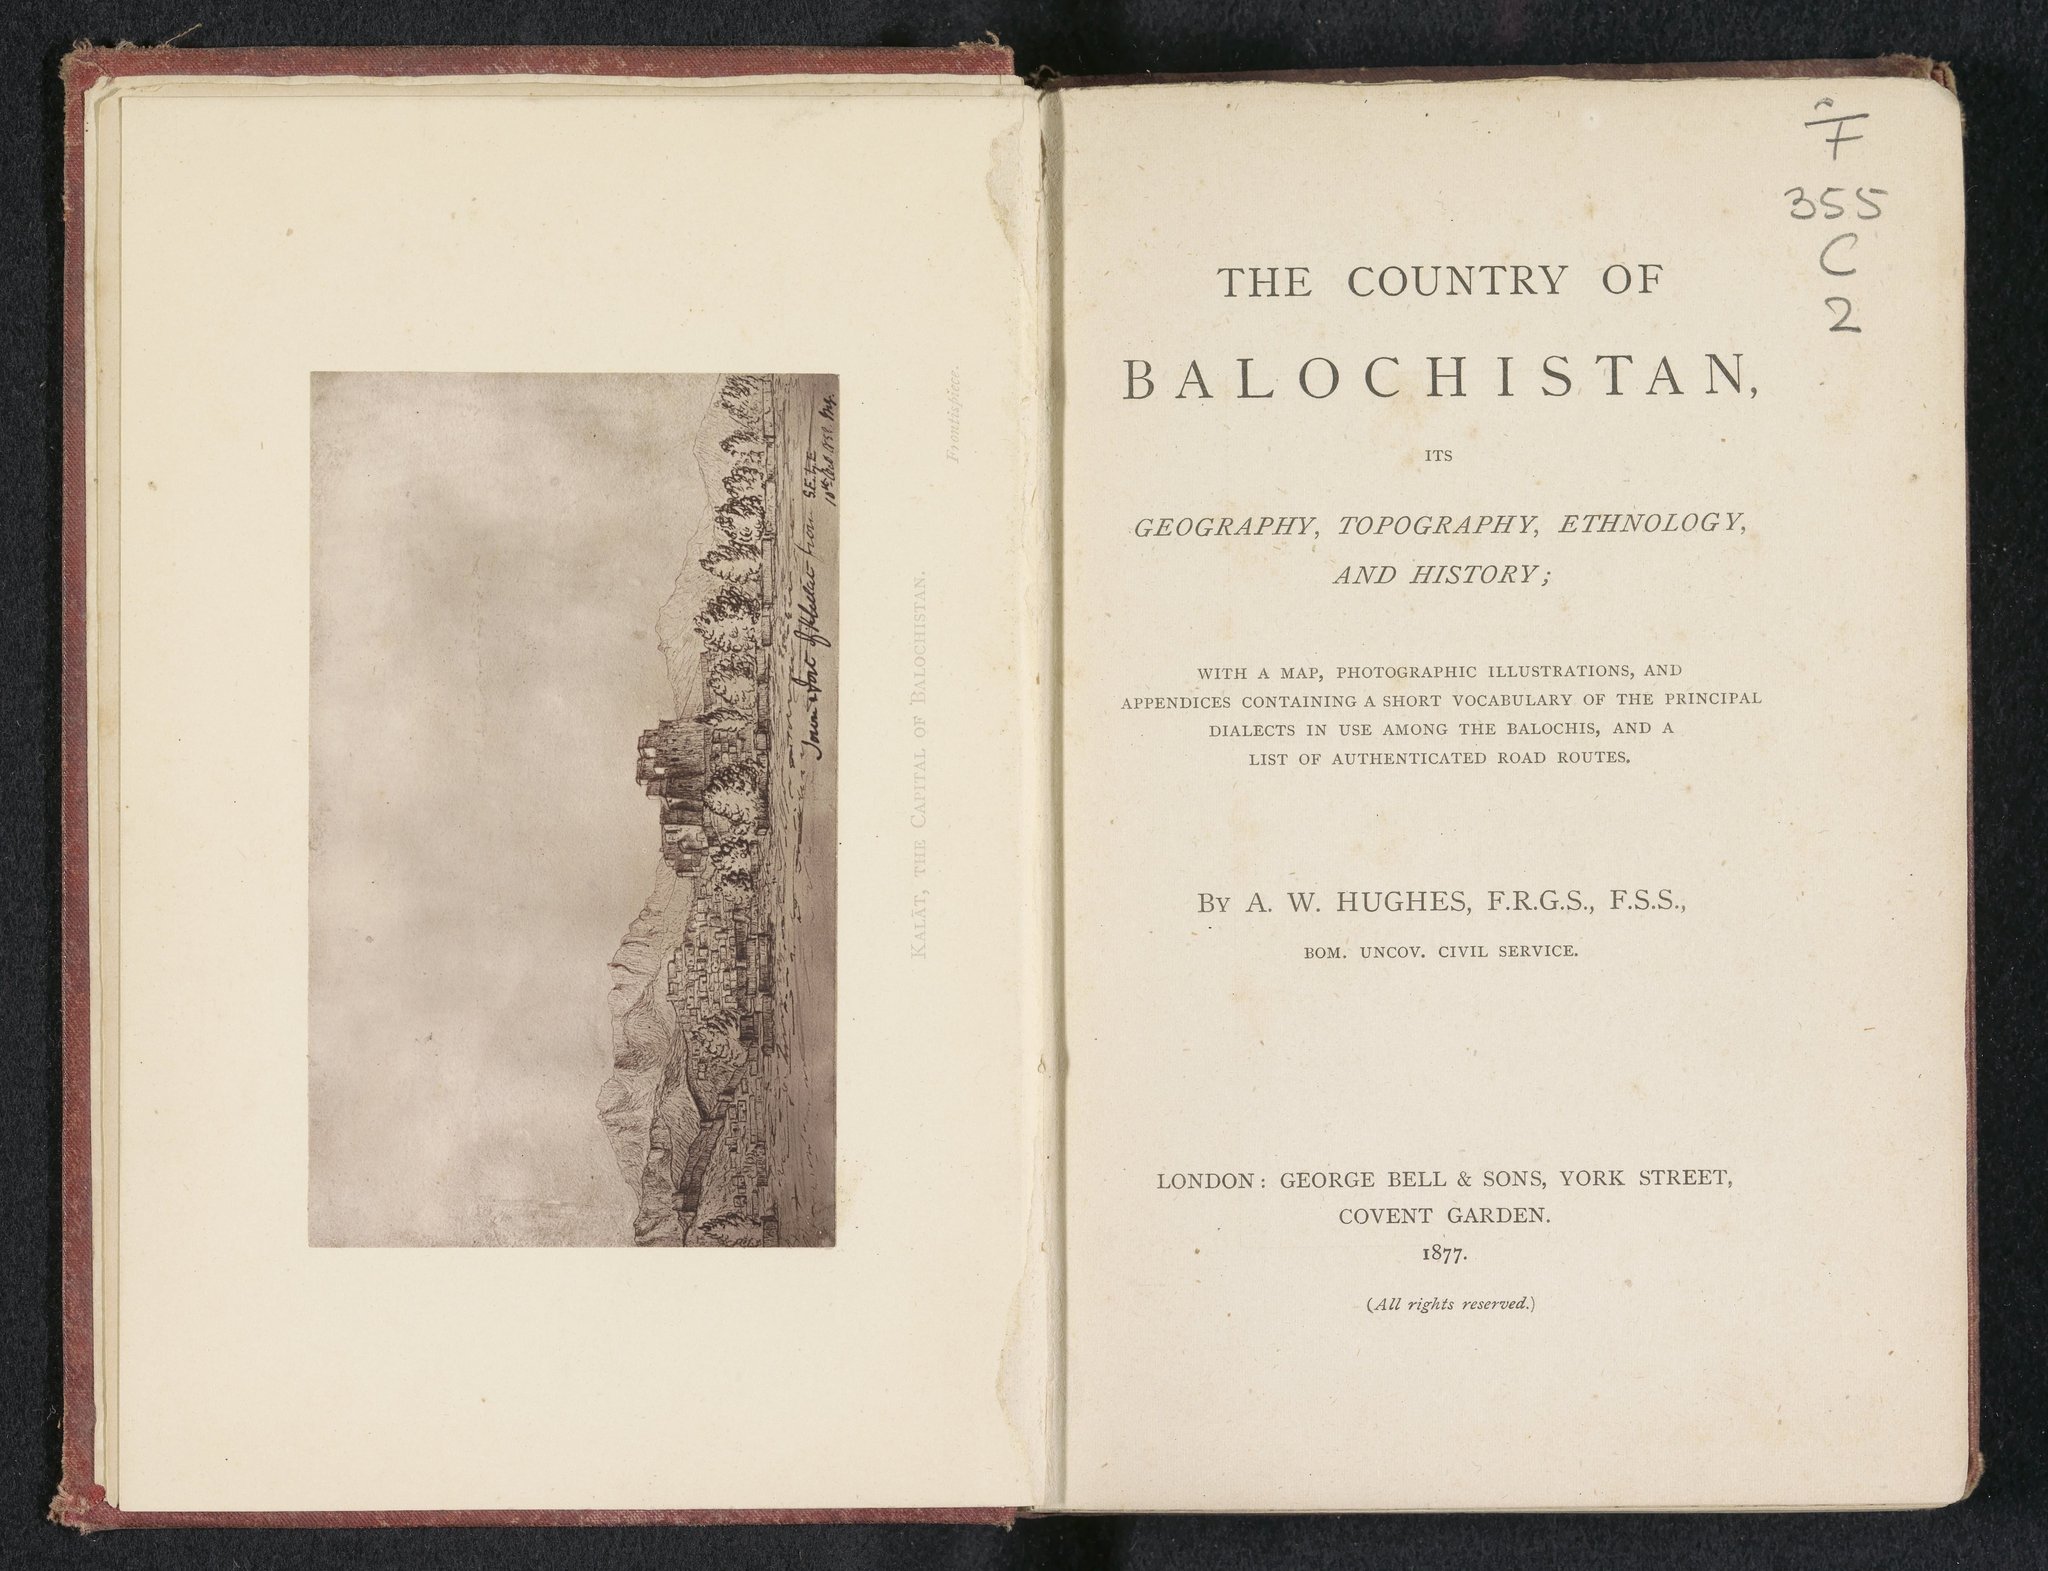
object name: book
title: The country of Balochistan, its geography, topography, ethnology, and history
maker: albert william hughes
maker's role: auteur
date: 1877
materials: cardboard, linen, paper, photographic support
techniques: lithograph, printing, woodburytype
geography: london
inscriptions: inscription: ‘[...] Hydrabad Sind’, number: ‘442’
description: Kaart van Balochistan aanwezig in sleuf in de achterkaft.